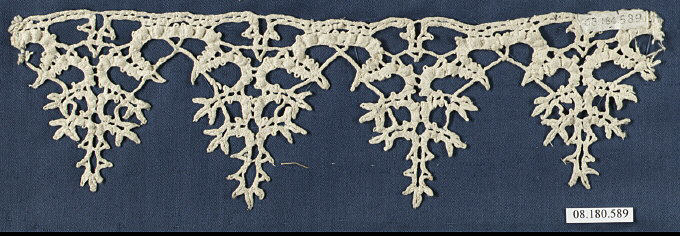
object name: fragment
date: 1501-1600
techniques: lace